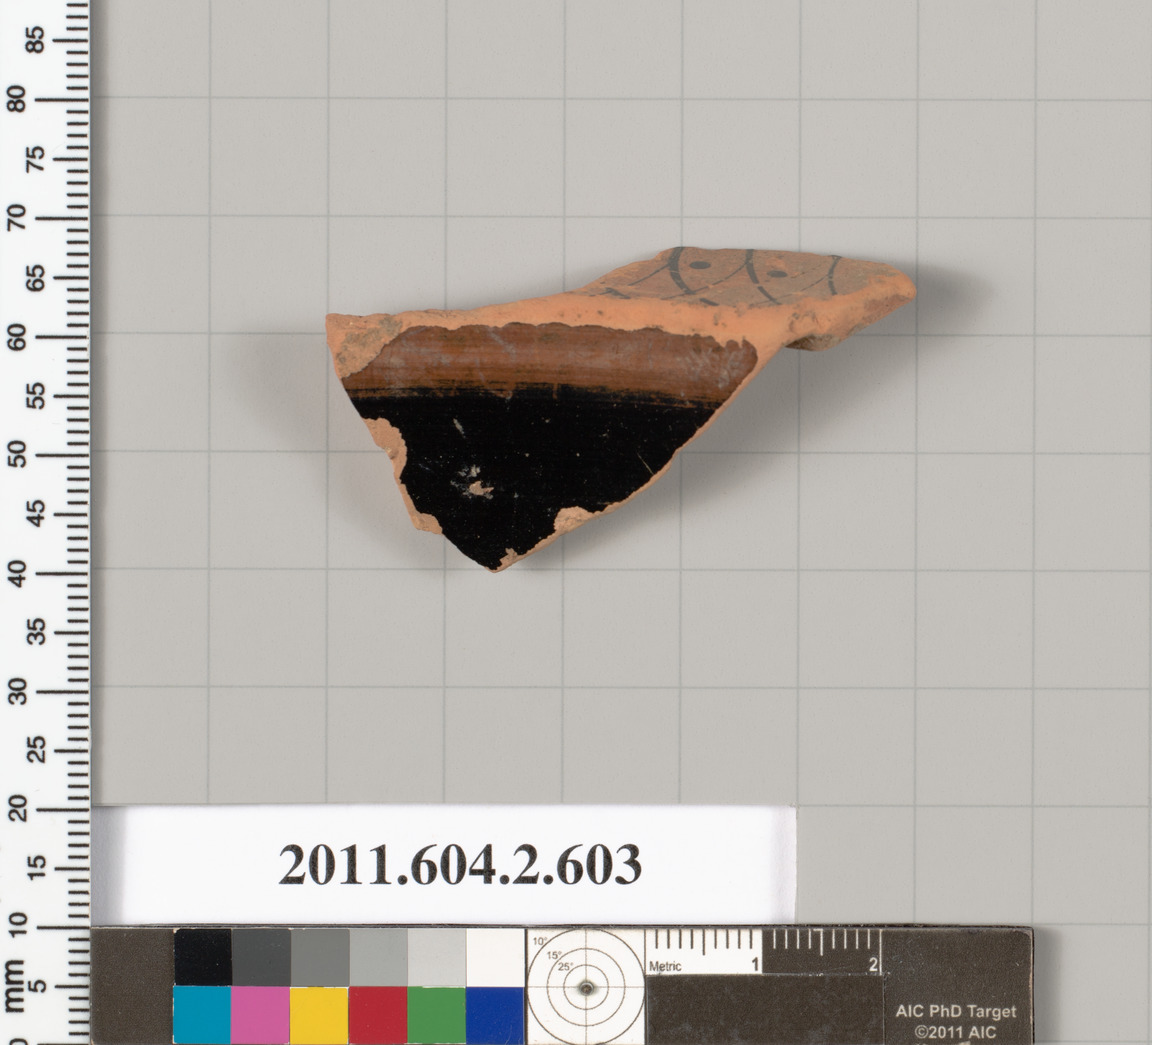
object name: column krater fragment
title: Terracotta fragment of a column-krater (bowl for mixing wine and water)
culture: greek, attic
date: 475-451 BCE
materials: terracotta